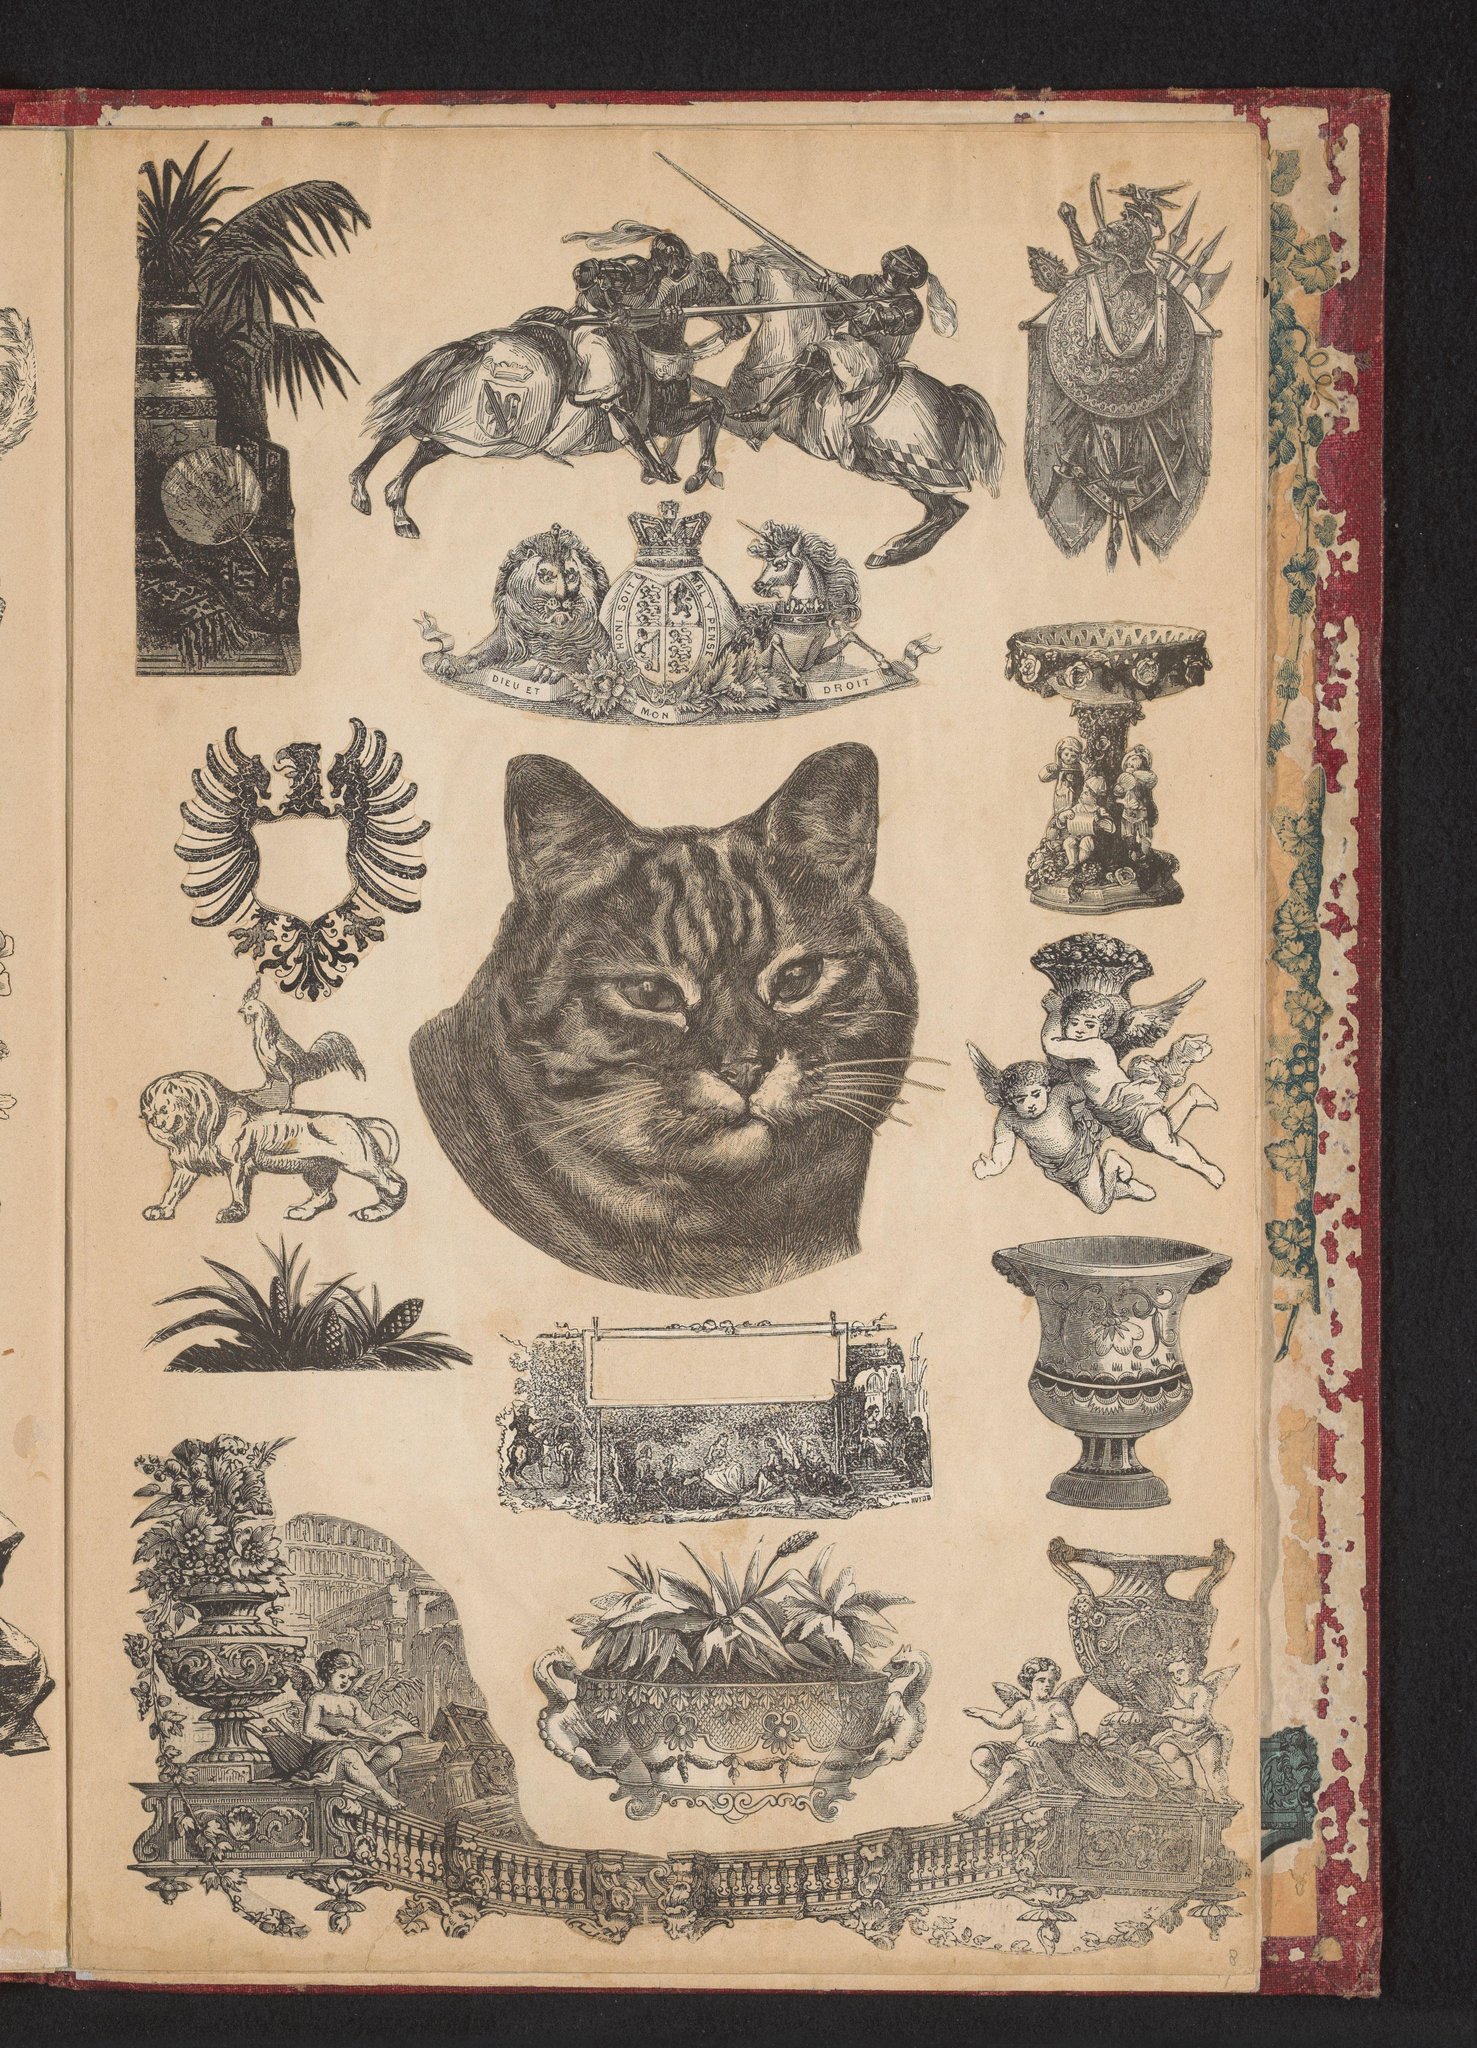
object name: collage visual work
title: Collage van uitgeknipte prenten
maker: Anonymous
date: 1870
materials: paper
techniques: engraving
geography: paris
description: Collage van uitgeknipte prenten. Onderdeel van een album met 18 bladen, aan beide zijden beplakt met uitgeknipte prenten, vermoedelijk afkomstig uit 19e-eeuwse tijdschiften.